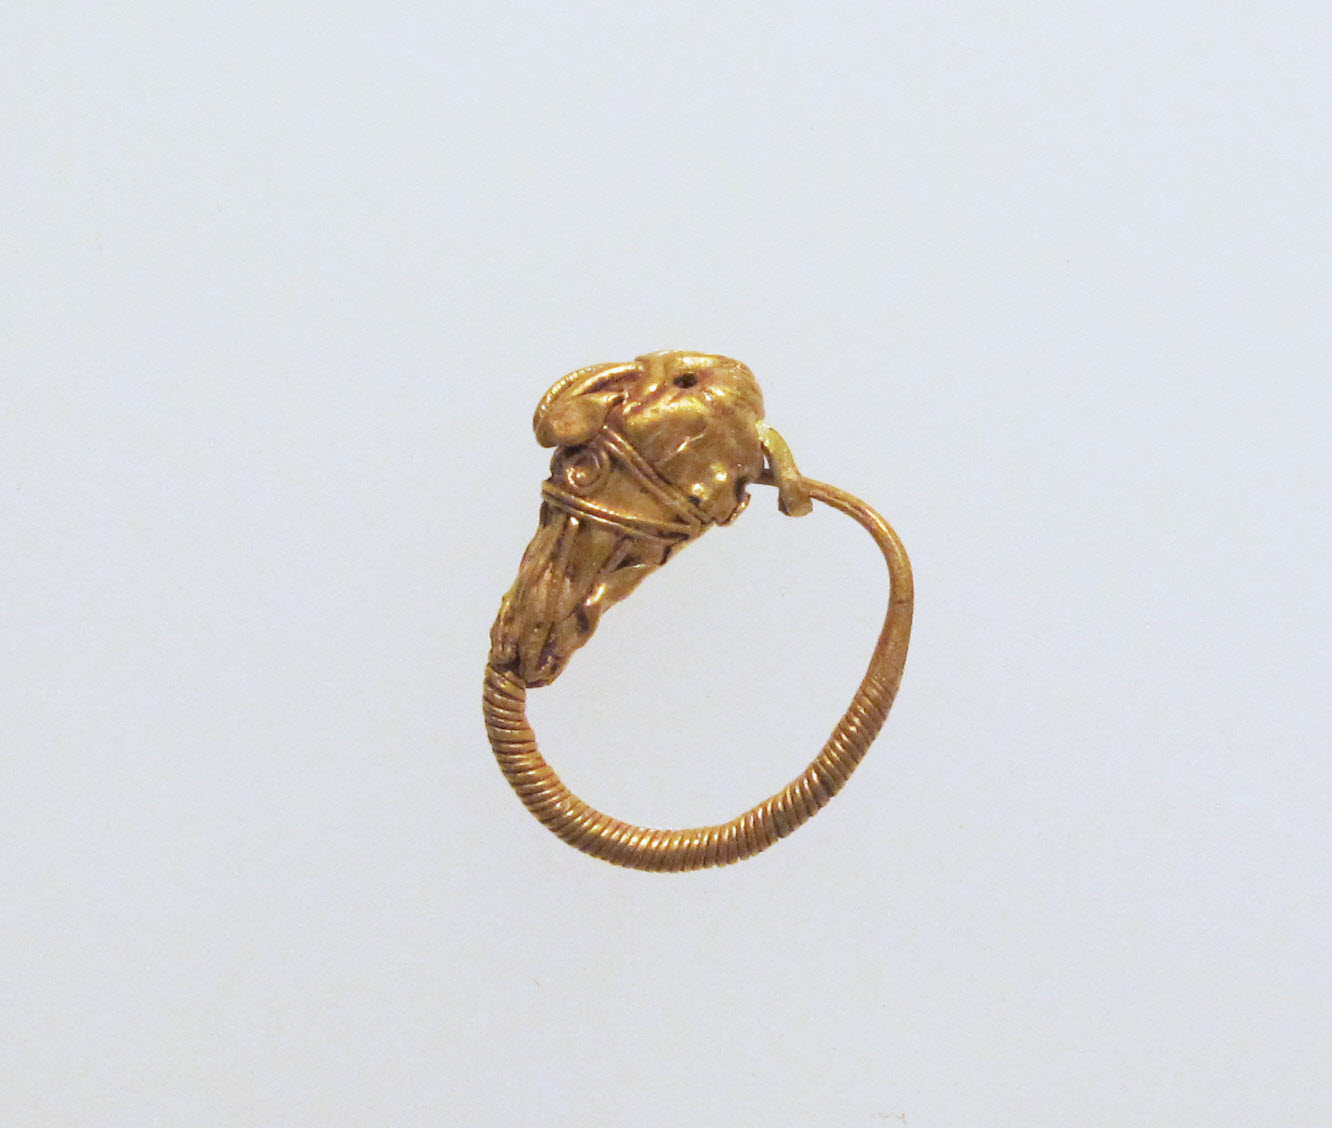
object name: earring with head of animal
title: Gold earring with head of an animal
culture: greek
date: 400-201 BCE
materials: gold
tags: animals